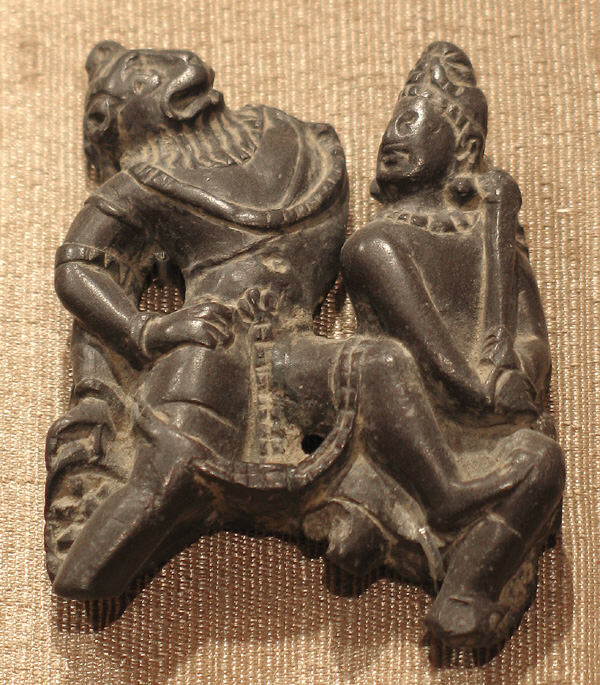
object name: relief fragment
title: Narasimha, the Man-Lion Incarnation of Vishnu, Slaying the Evil King Hiranyakashipu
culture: india, jammu & kashmir or pakistan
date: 501-700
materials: stone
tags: kashmir,vishnu